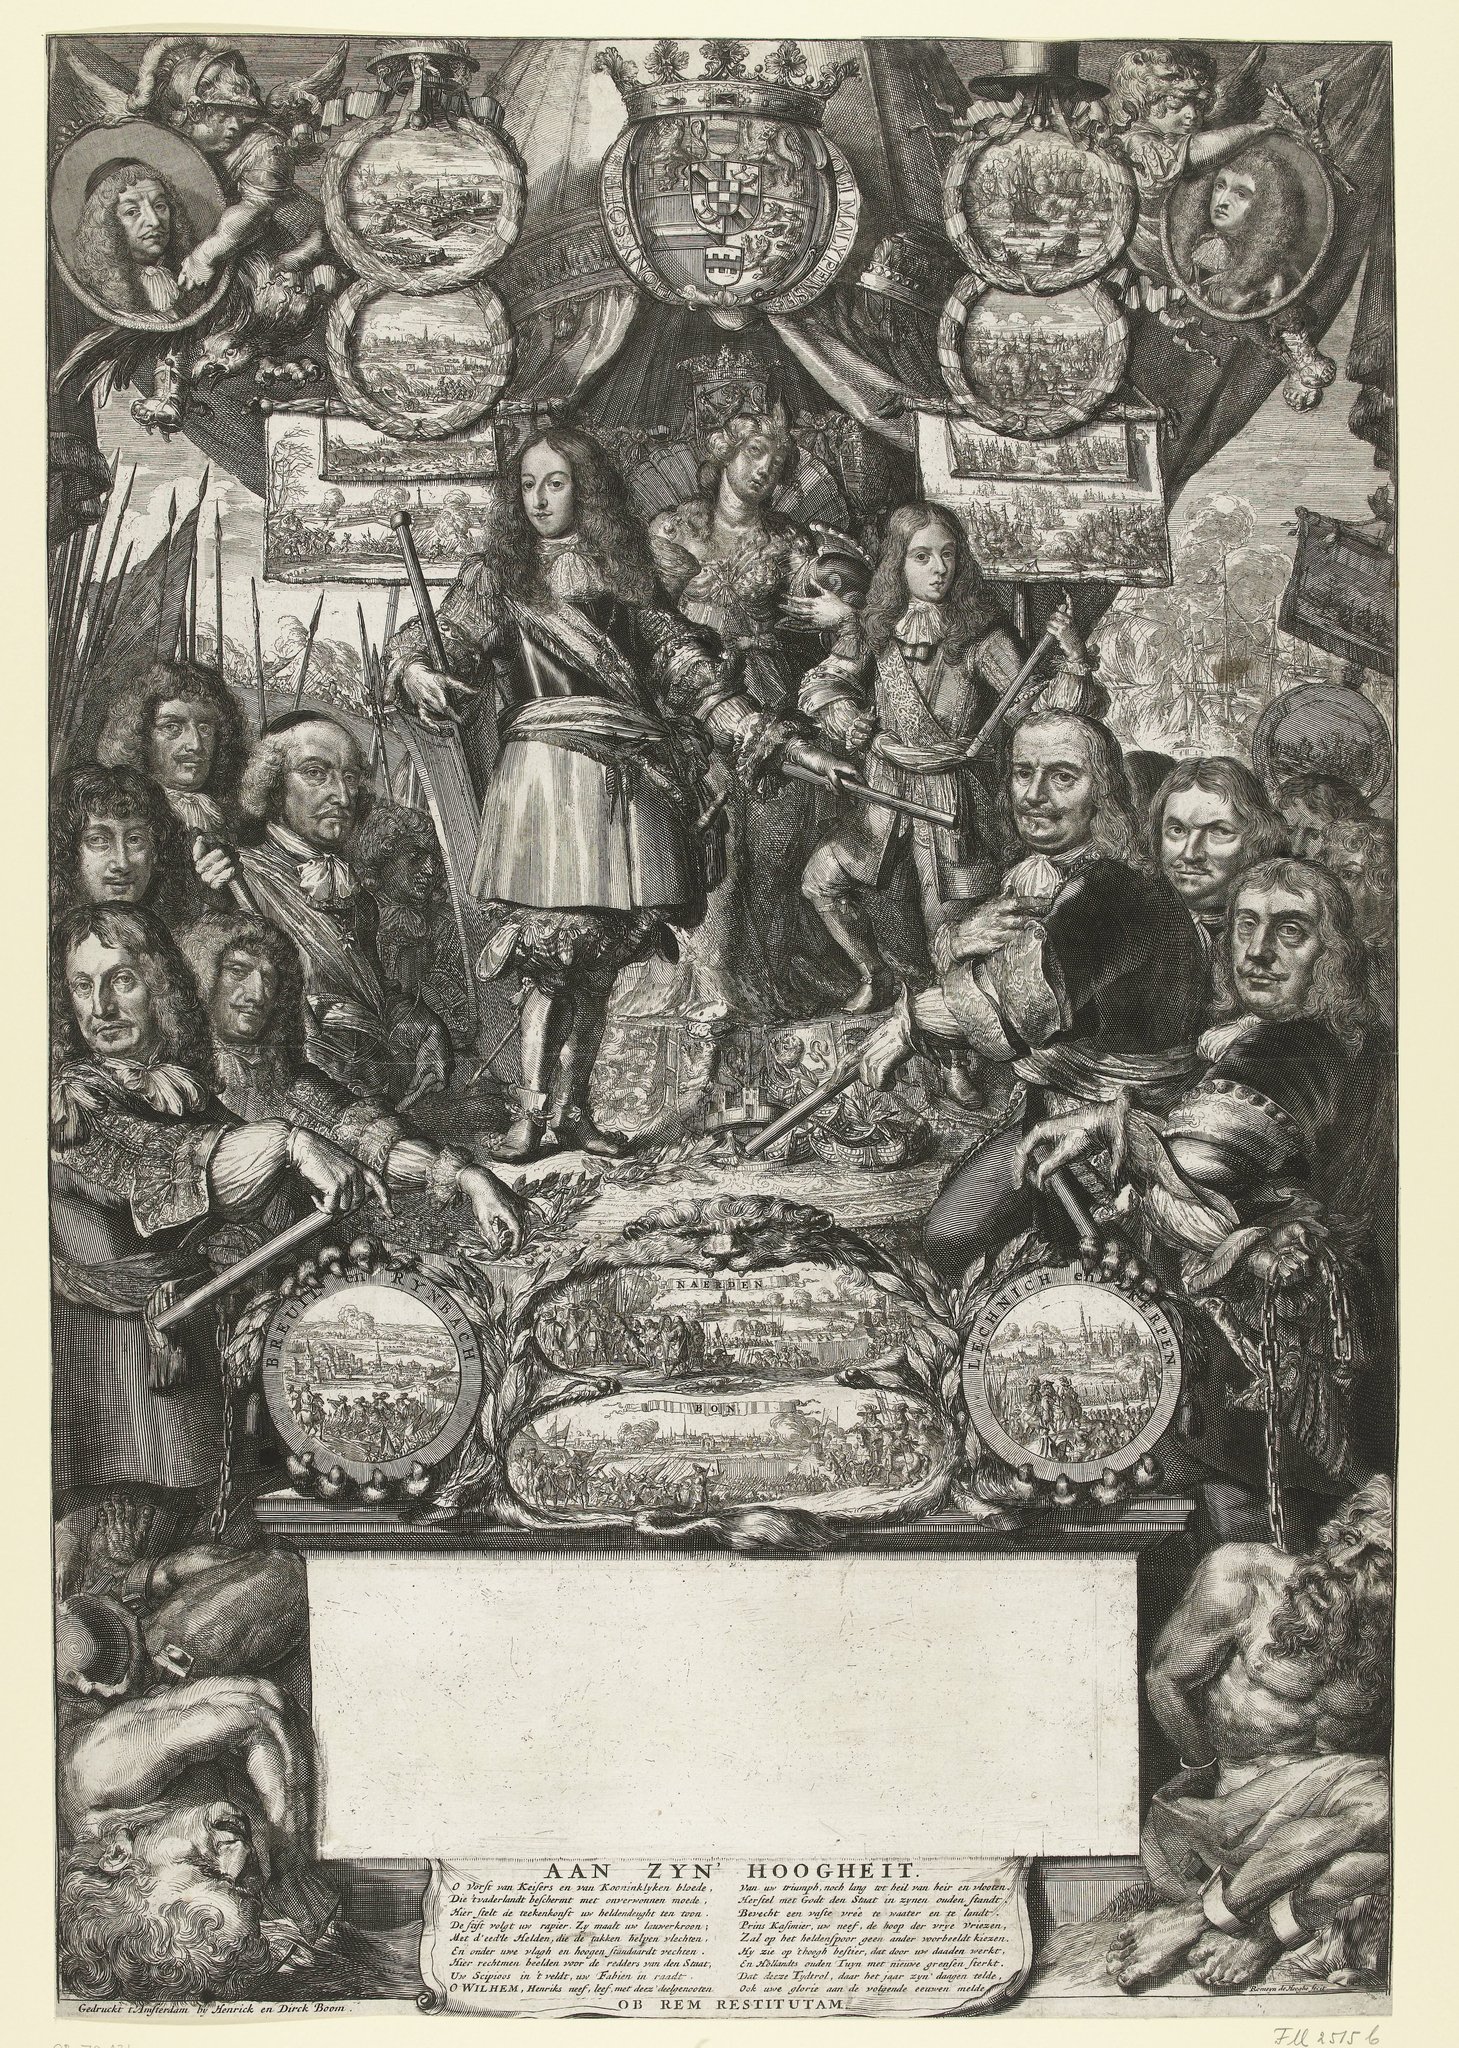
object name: print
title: Allegorie op de overwinningen van Willem III in 1673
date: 1673-1674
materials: paper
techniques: engraving, etching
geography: northern netherlands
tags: flushing, michiel adriaenszoon de ruyter, rotterdam, amsterdam, cornelis tromp, earl, johan maurits graaf van nassau-siegen, william iii (prince of orange and king of england, scotland, and ireland), juan domingo méndez de haro y fernández de córdoba, hendrik casimir ii graaf van nassau-dietz, commander-in-chief, general, marshal, prince, military glory, commander-in-chief, admiral, rampjaar (disaster year)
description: Allegorie op de overwinningen van Willem III in 1673. De jonge prins met commandostaf staande naast de jonge Hendrik Casimir. Hiervoor bevelhebbers die in 1673 overwinningen behaalden: Michiel Adriaenszoon de Ruyter, Cornelis Tromp, Adriaen Banckert, Johan Maurits, Paulus Wirtz, George Frederik van Waldeck, Rabenhaupt en graaf Willem van Hornes. Hieromheen medaillons en cartouches met overwinningen. Bovenaan links het portret van Montecuccoli en rechts Monterrey. Onderaan een open ruimte bestemd voor de almanak voor het jaar 1674. Aan weerszijden geketende gevangenen. In de plaat onderaan een vers in twee kolommen in het Nederlands gericht aan de vorst.